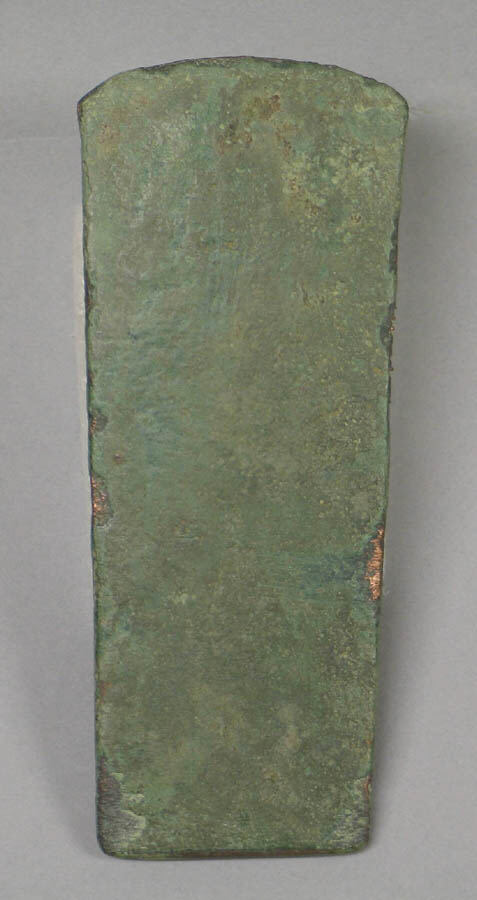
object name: ax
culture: indian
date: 1500-500 BCE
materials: copper